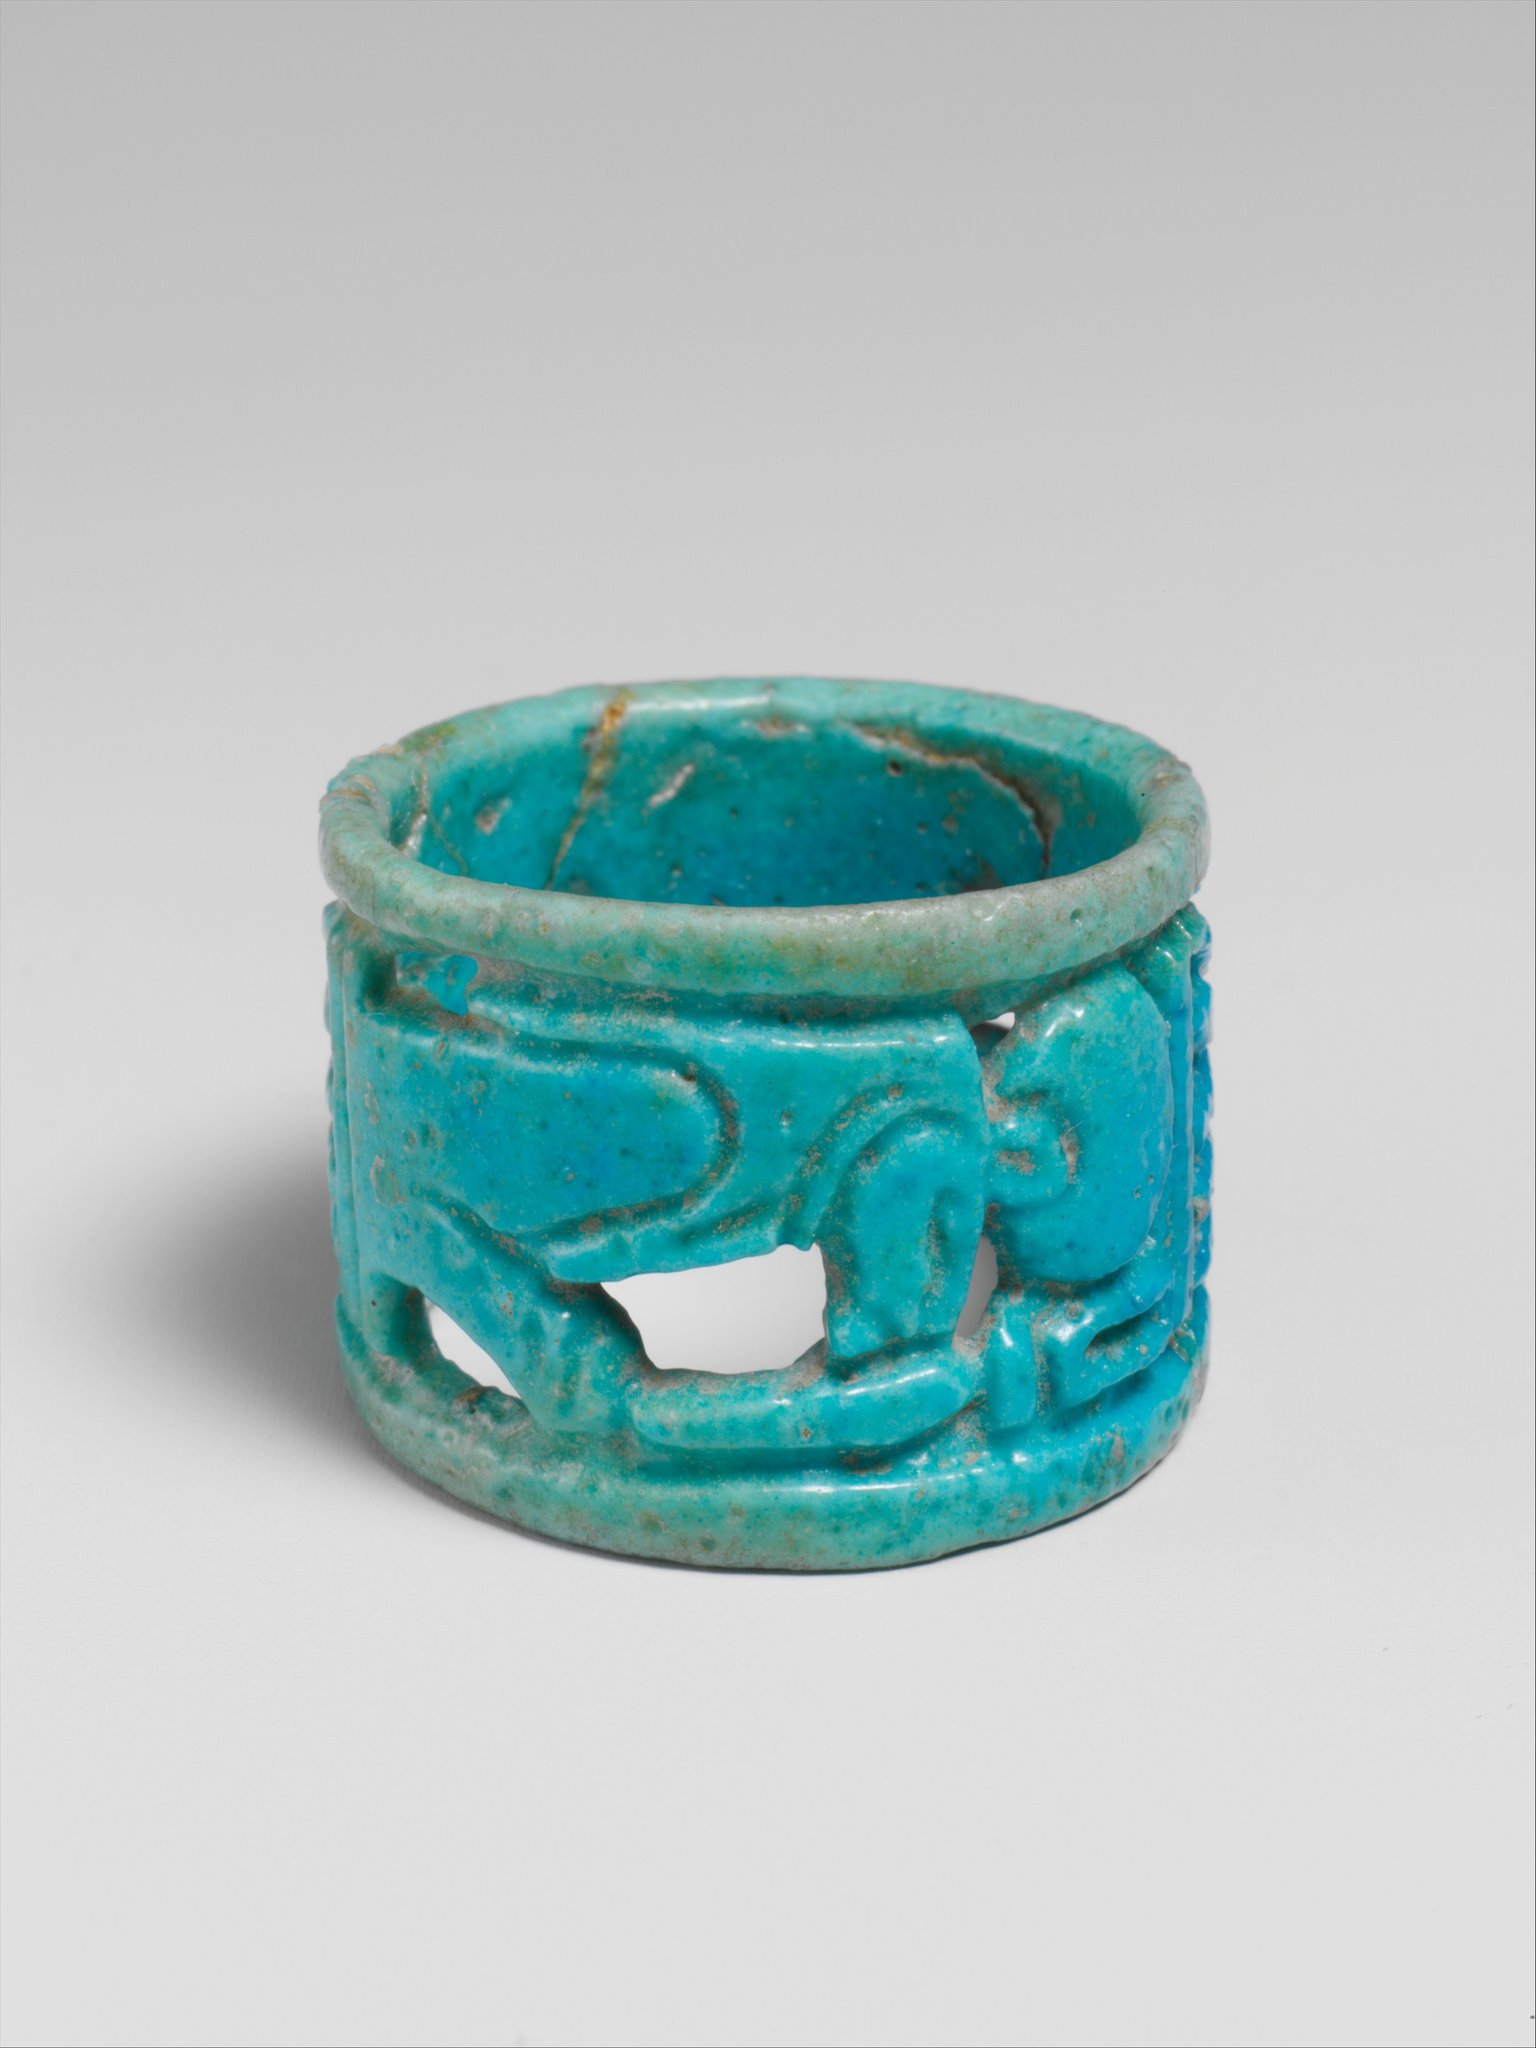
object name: ring, openwork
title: Faience band ring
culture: egyptian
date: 1060-900 BCE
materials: faience